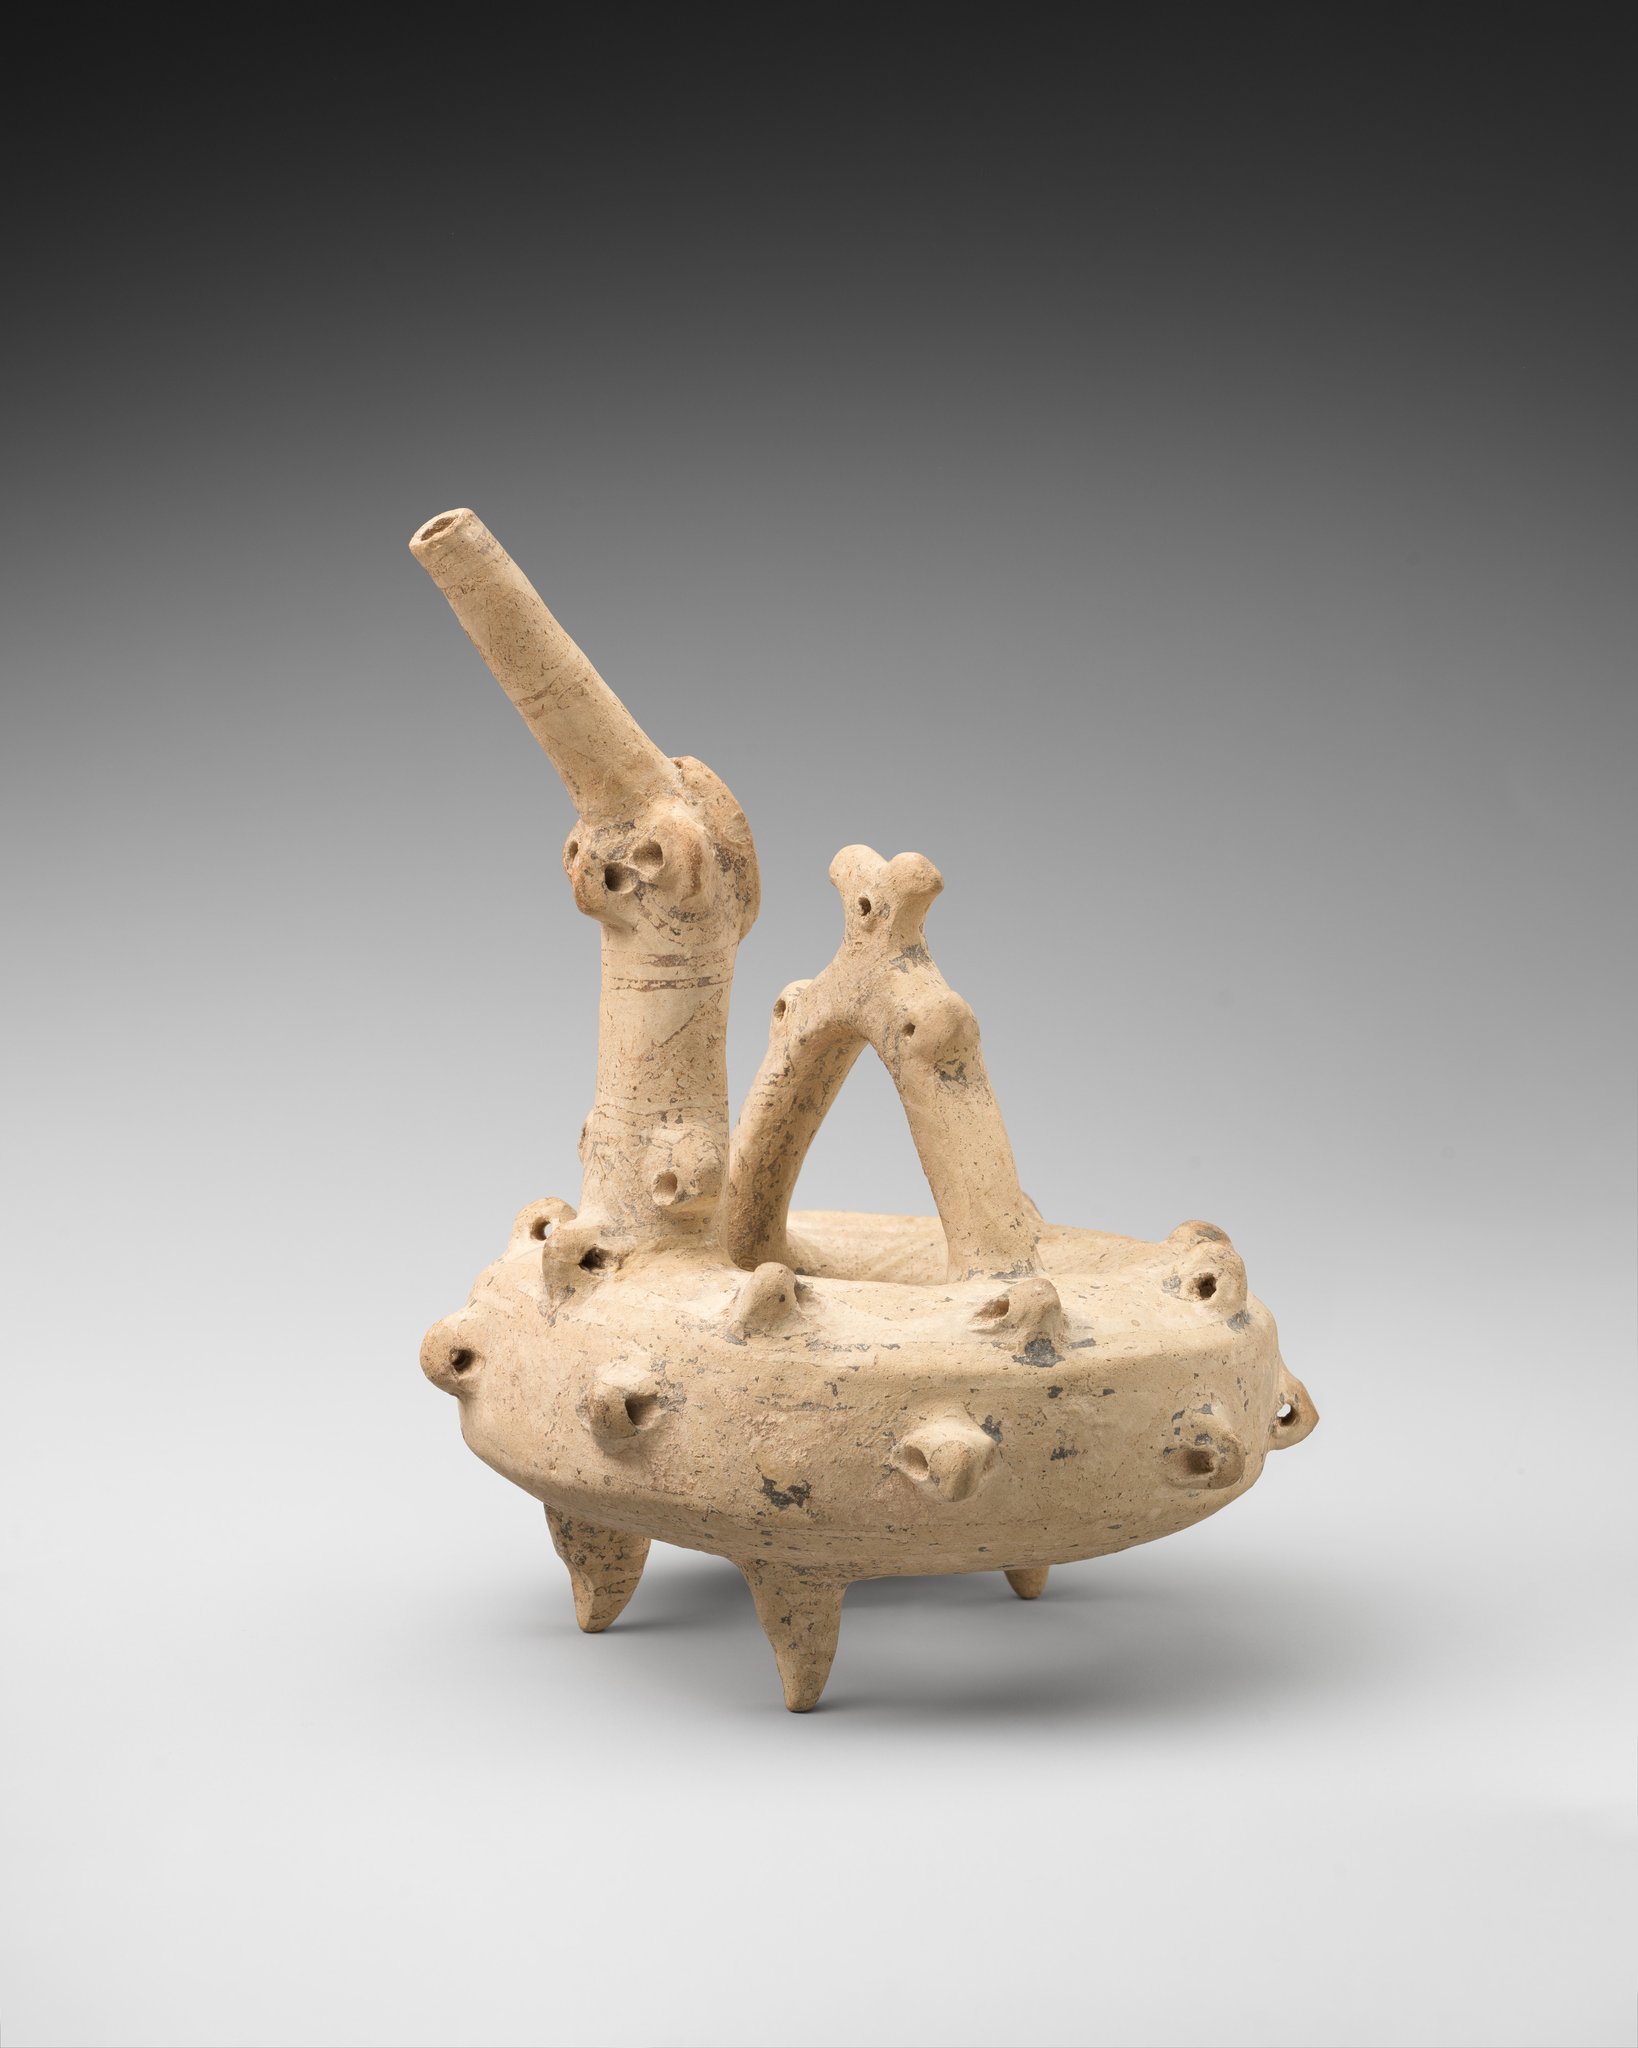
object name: ring vase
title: Terracotta ring vase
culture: cypriot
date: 1900-1600 BCE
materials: terracotta